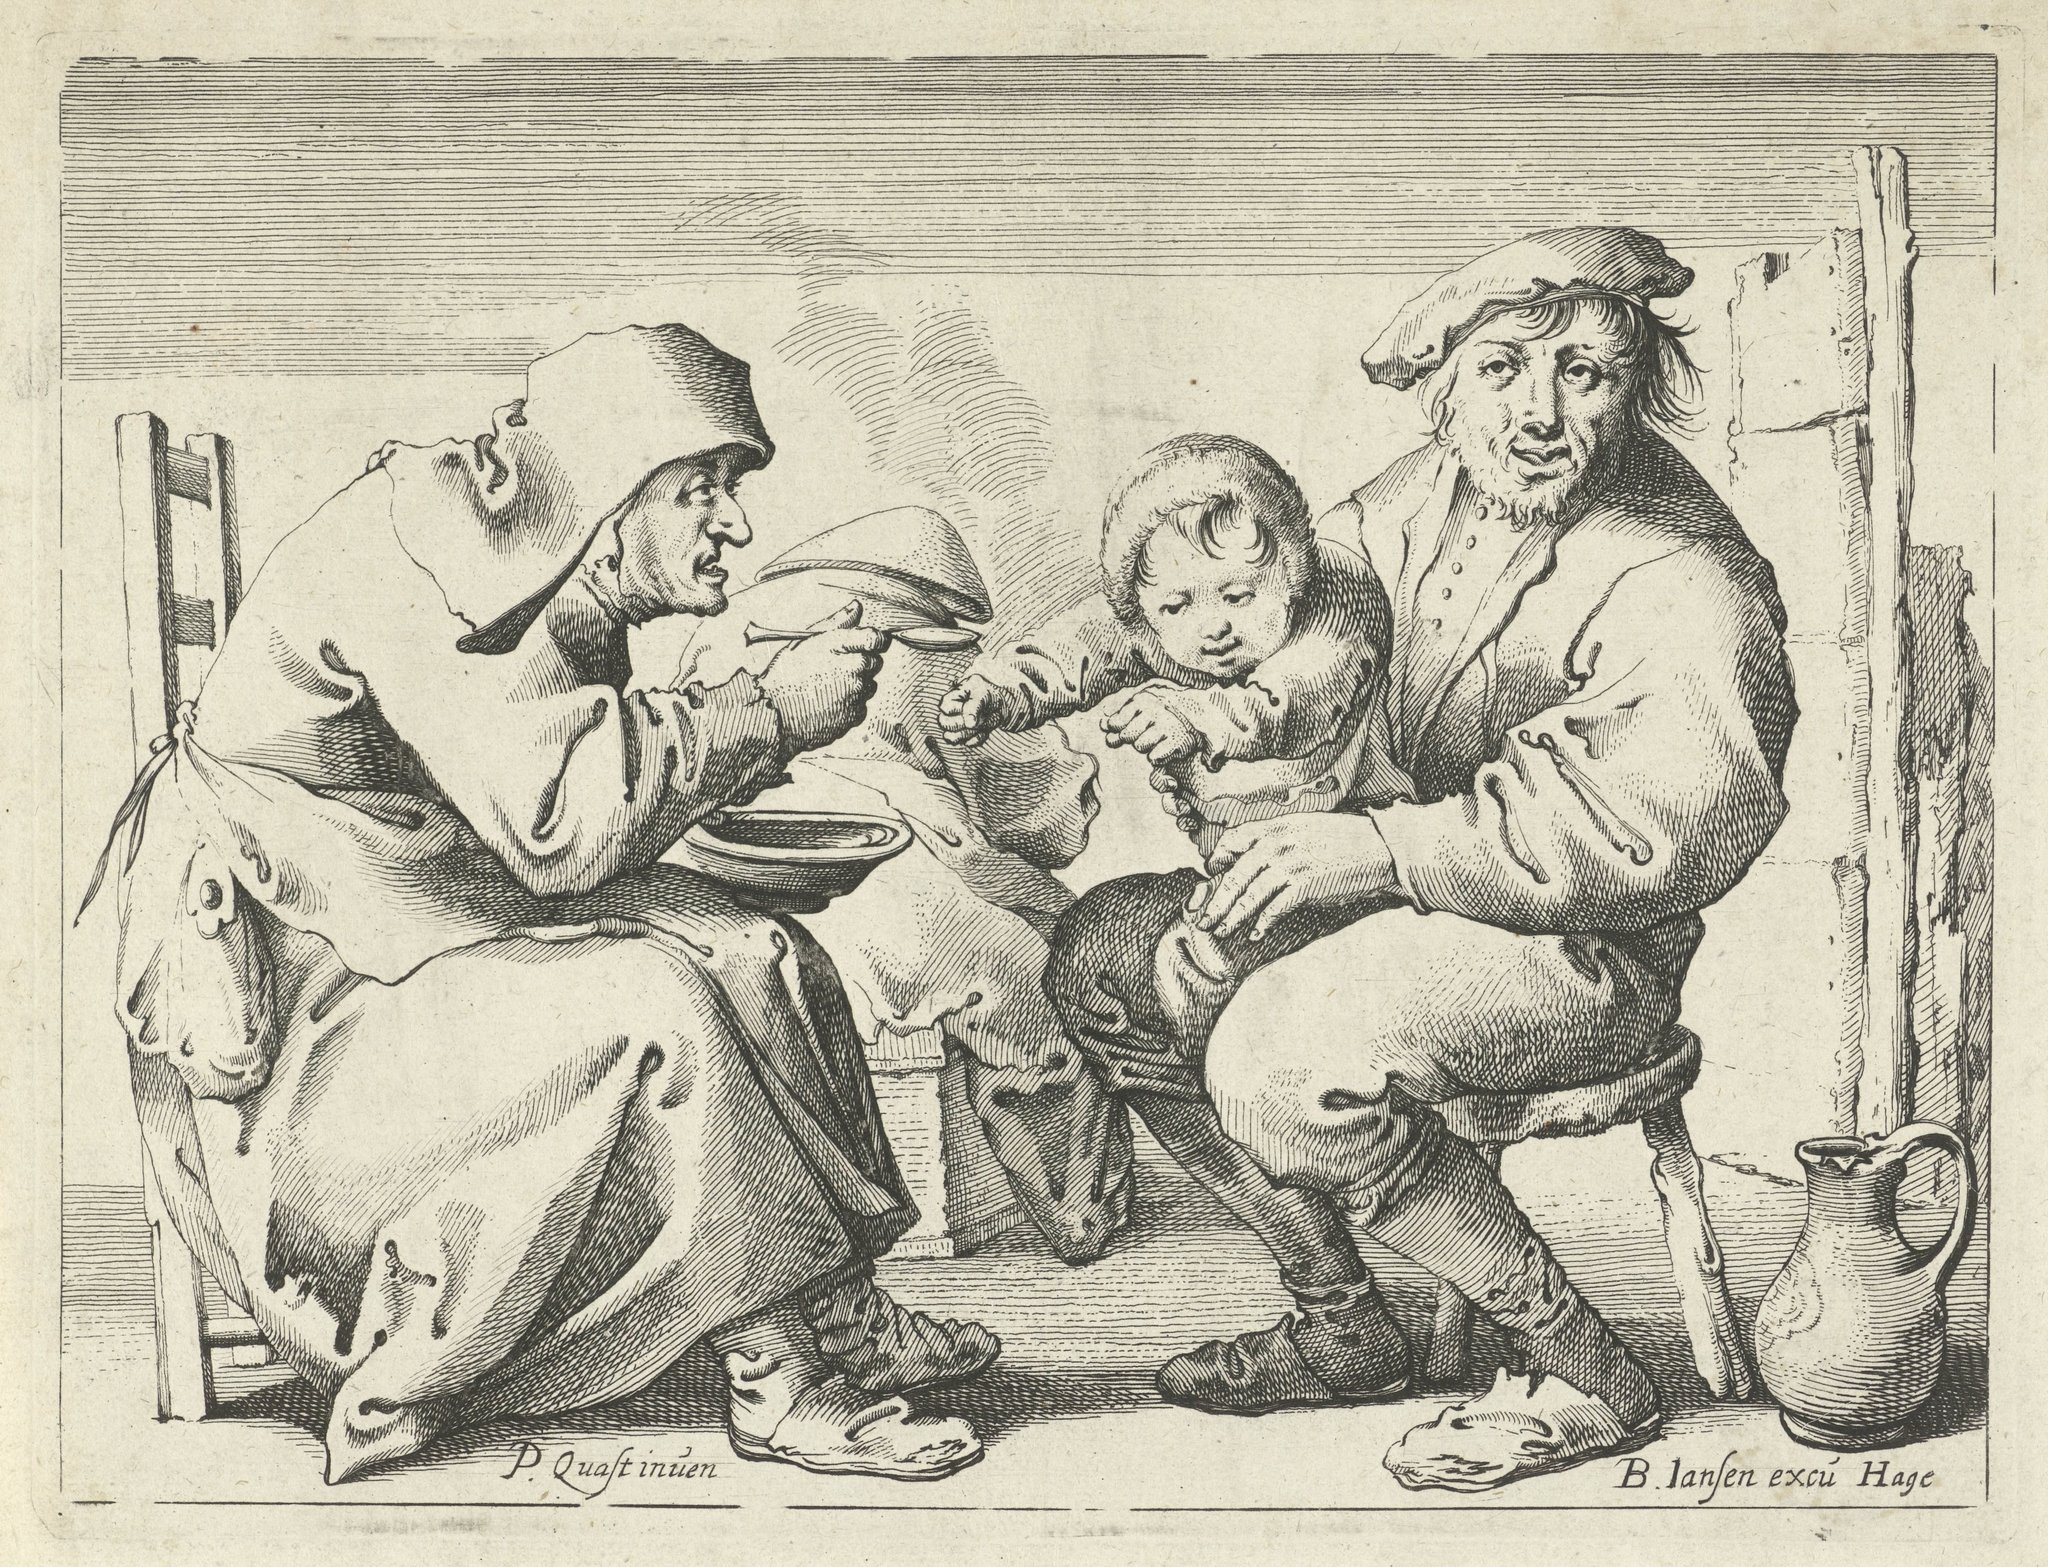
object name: print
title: Boerengezin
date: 1615-1647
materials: paper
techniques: engraving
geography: netherlands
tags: giving food, child, farmers - aa - female farmer, farmer's wife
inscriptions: collector's mark: Lugt 240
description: Een boerin voert een kind, die op de schoot van een boer zit, met een lepel. Op de achtergrond zit een tweede boerin bij het vuur.